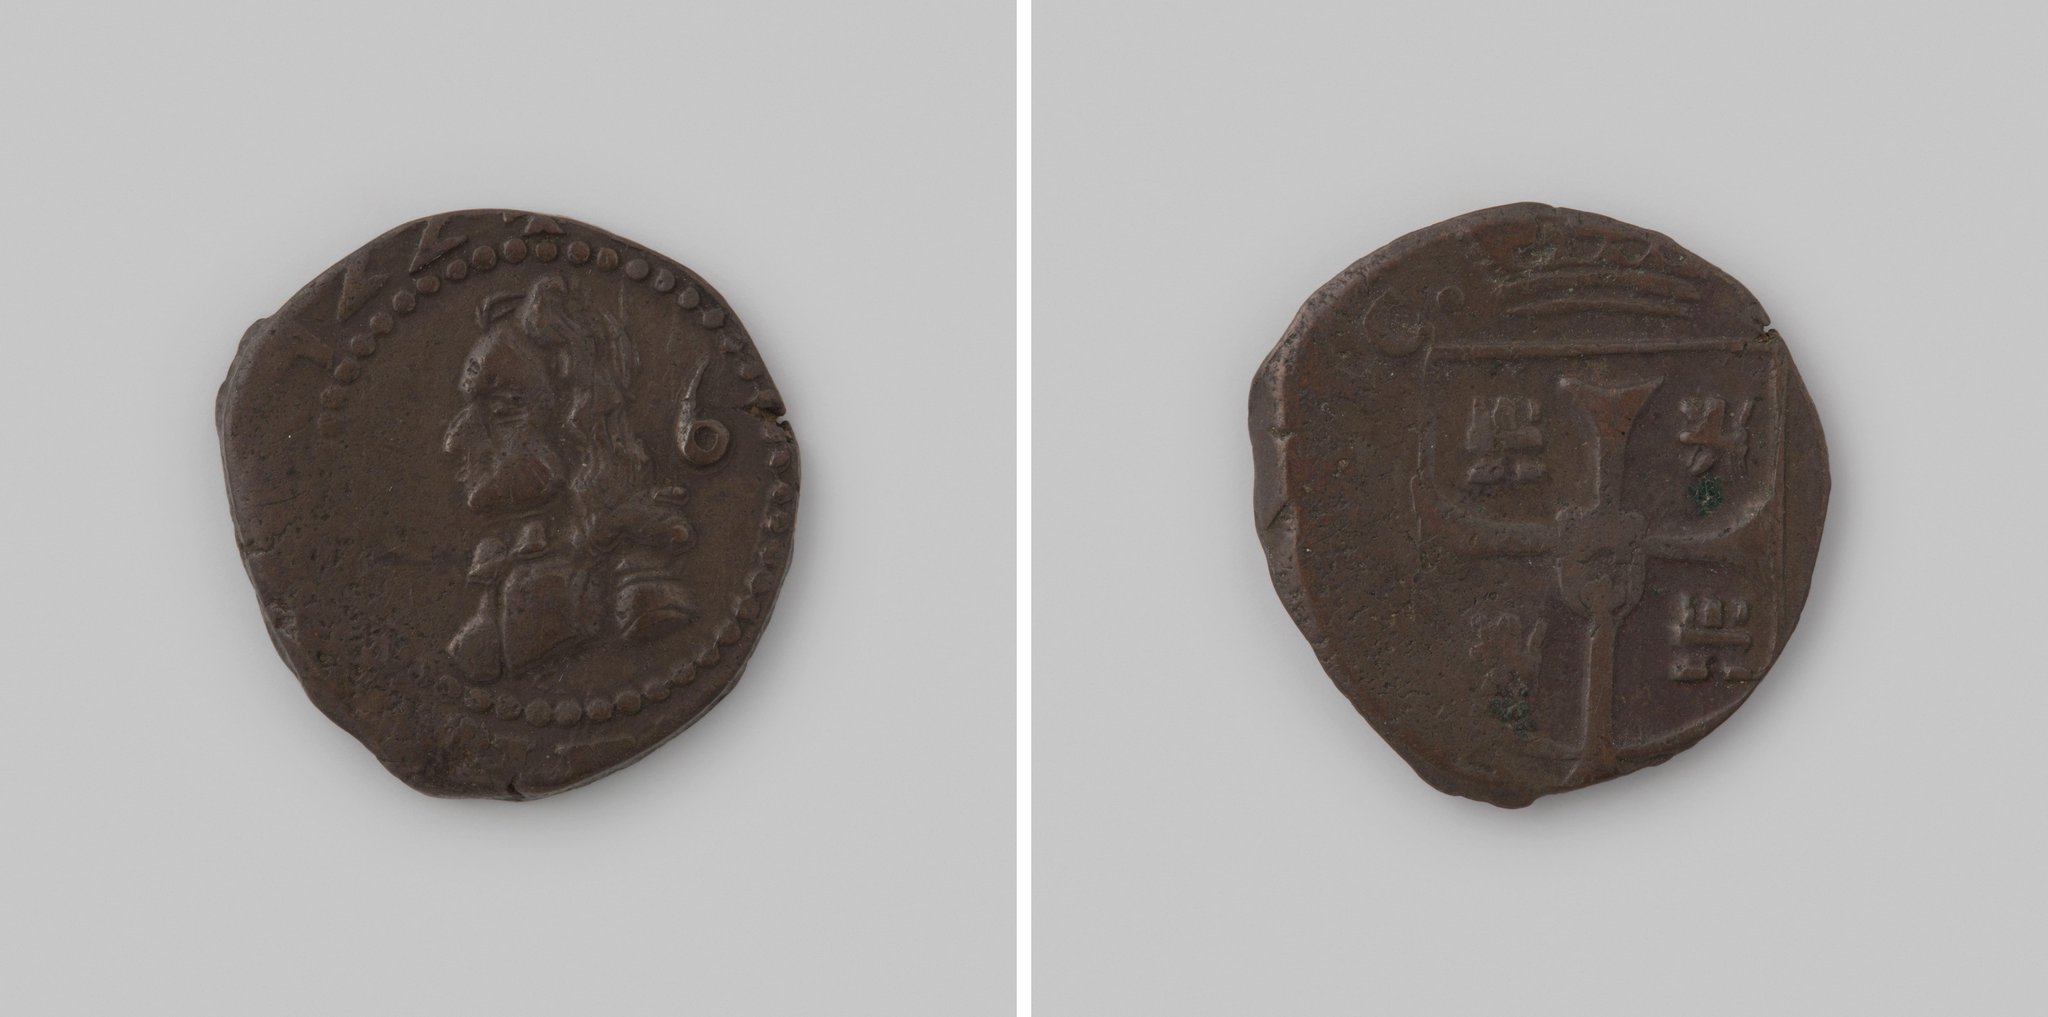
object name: coin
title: Treseta de cobre of 6 dineros uit de Balearen, Spanje van koning Philips V (IV in Mallorca), 1722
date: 1722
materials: copper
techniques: striking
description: Koperen munt. Voorzijde: portret van de koning naar links. Rechts daarvan waarde-aanduiding, 6. Jaartal bovenaan in omschrift. Keerzijde: gekroond Spaans wapenschild.